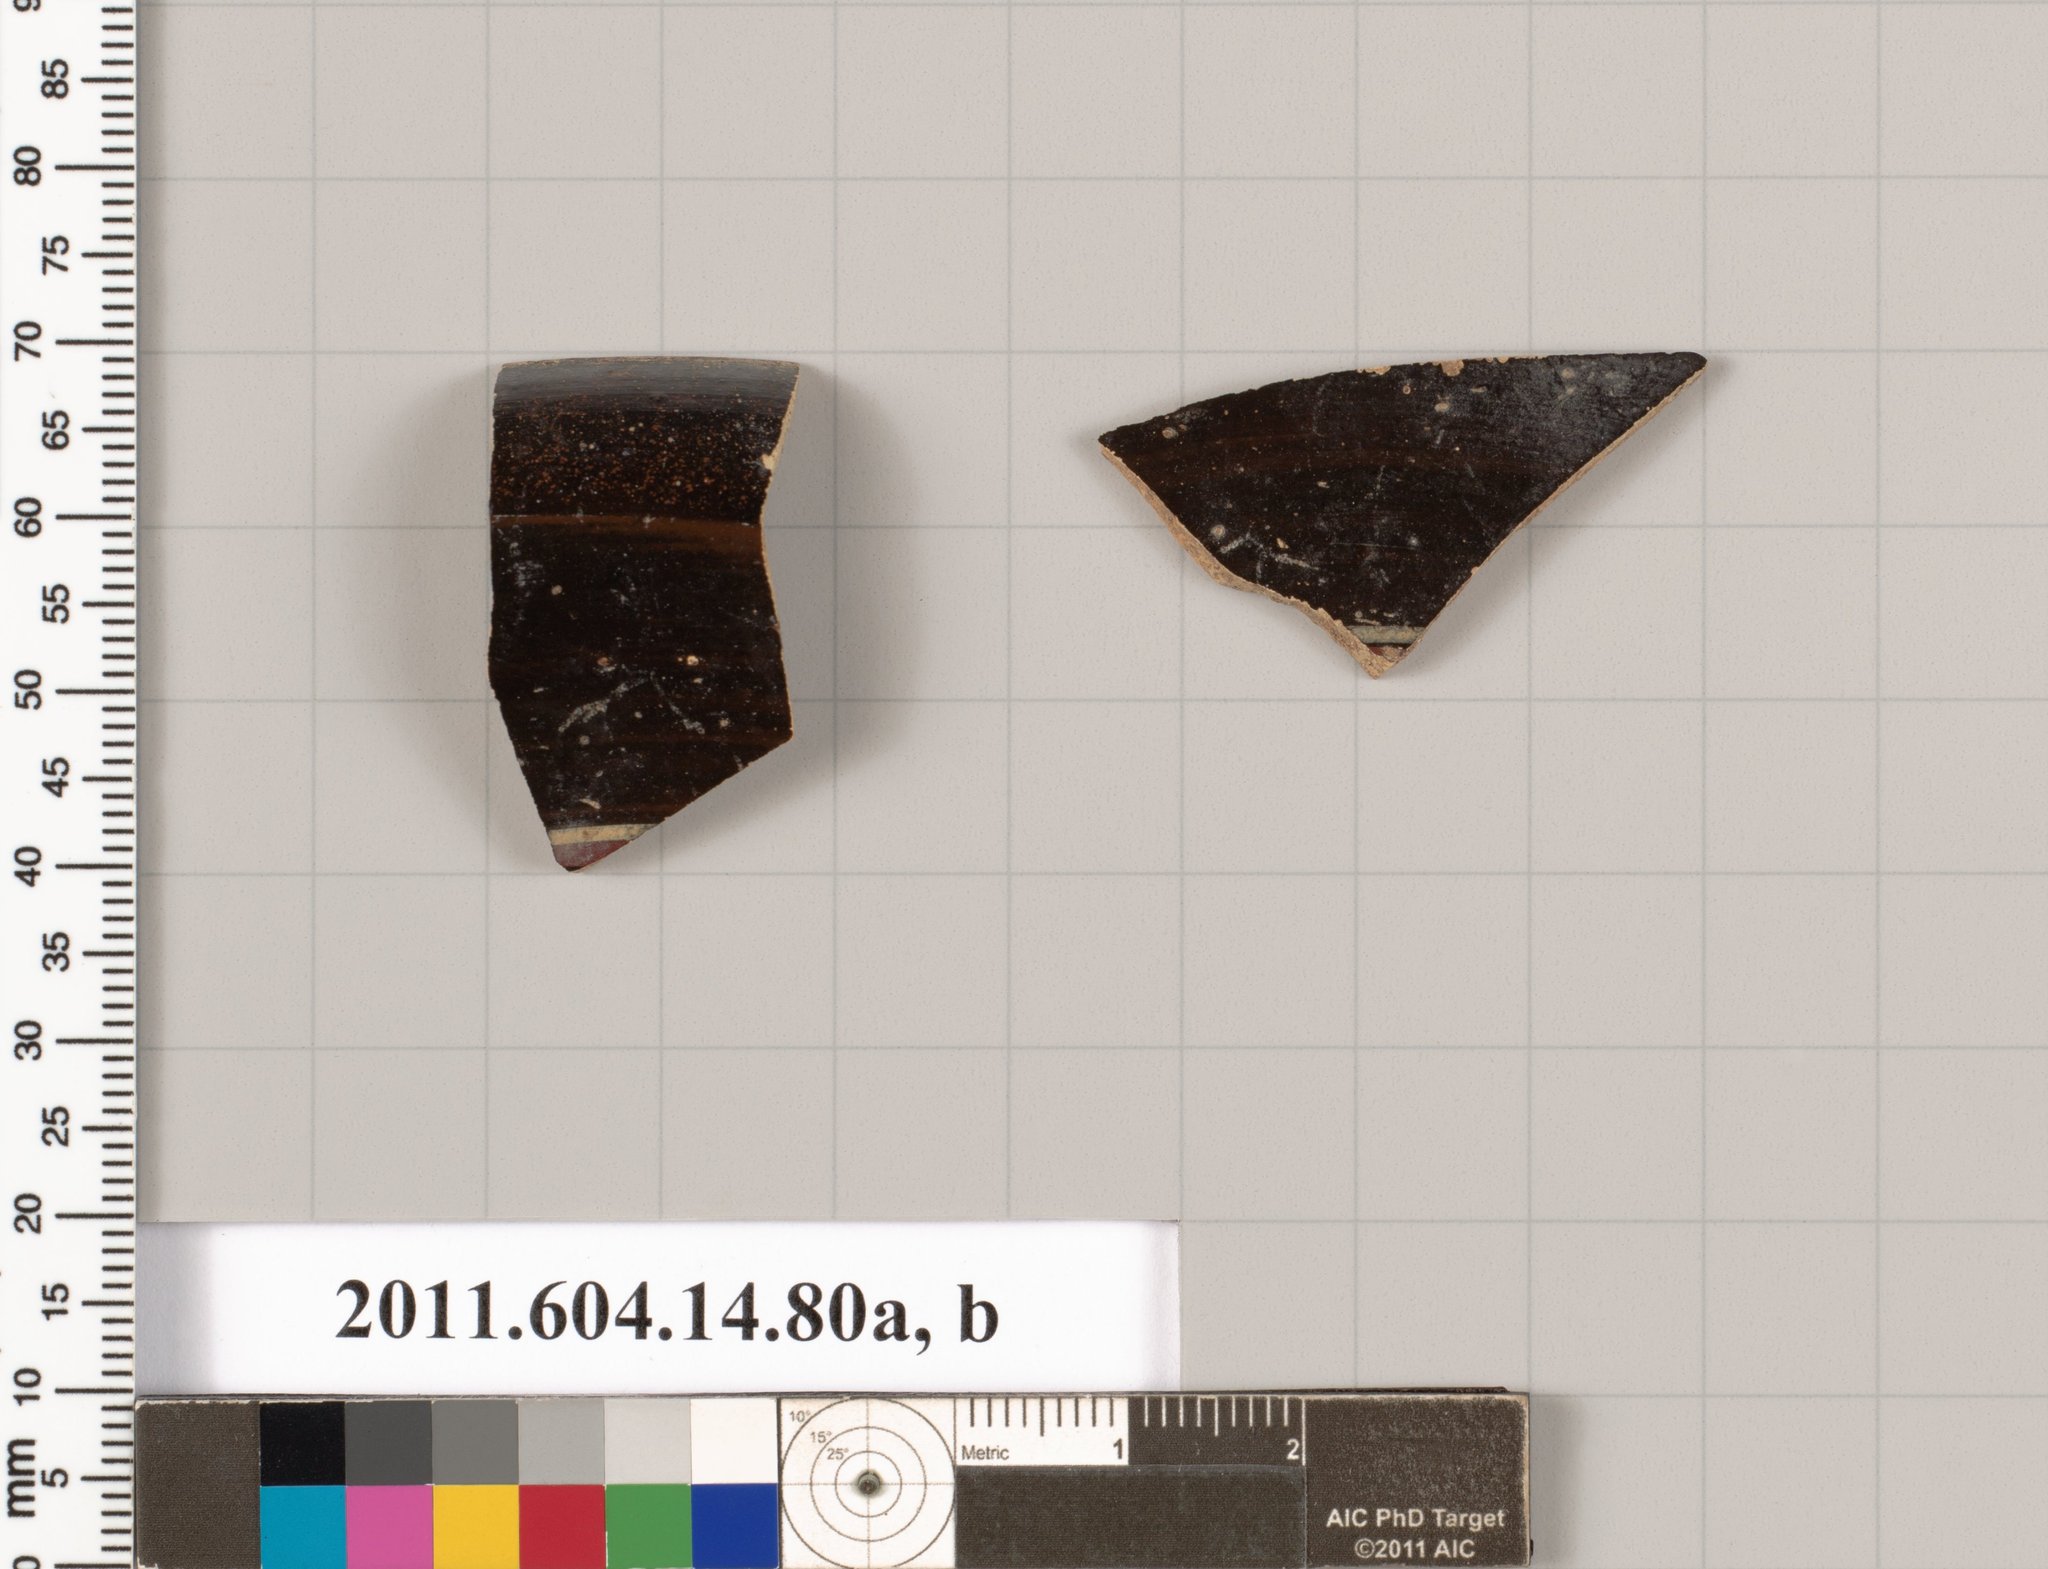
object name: kylix fragment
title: Terracotta fragments of a kylix (drinking cup)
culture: unknown fabric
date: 600-401 BCE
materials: terracotta